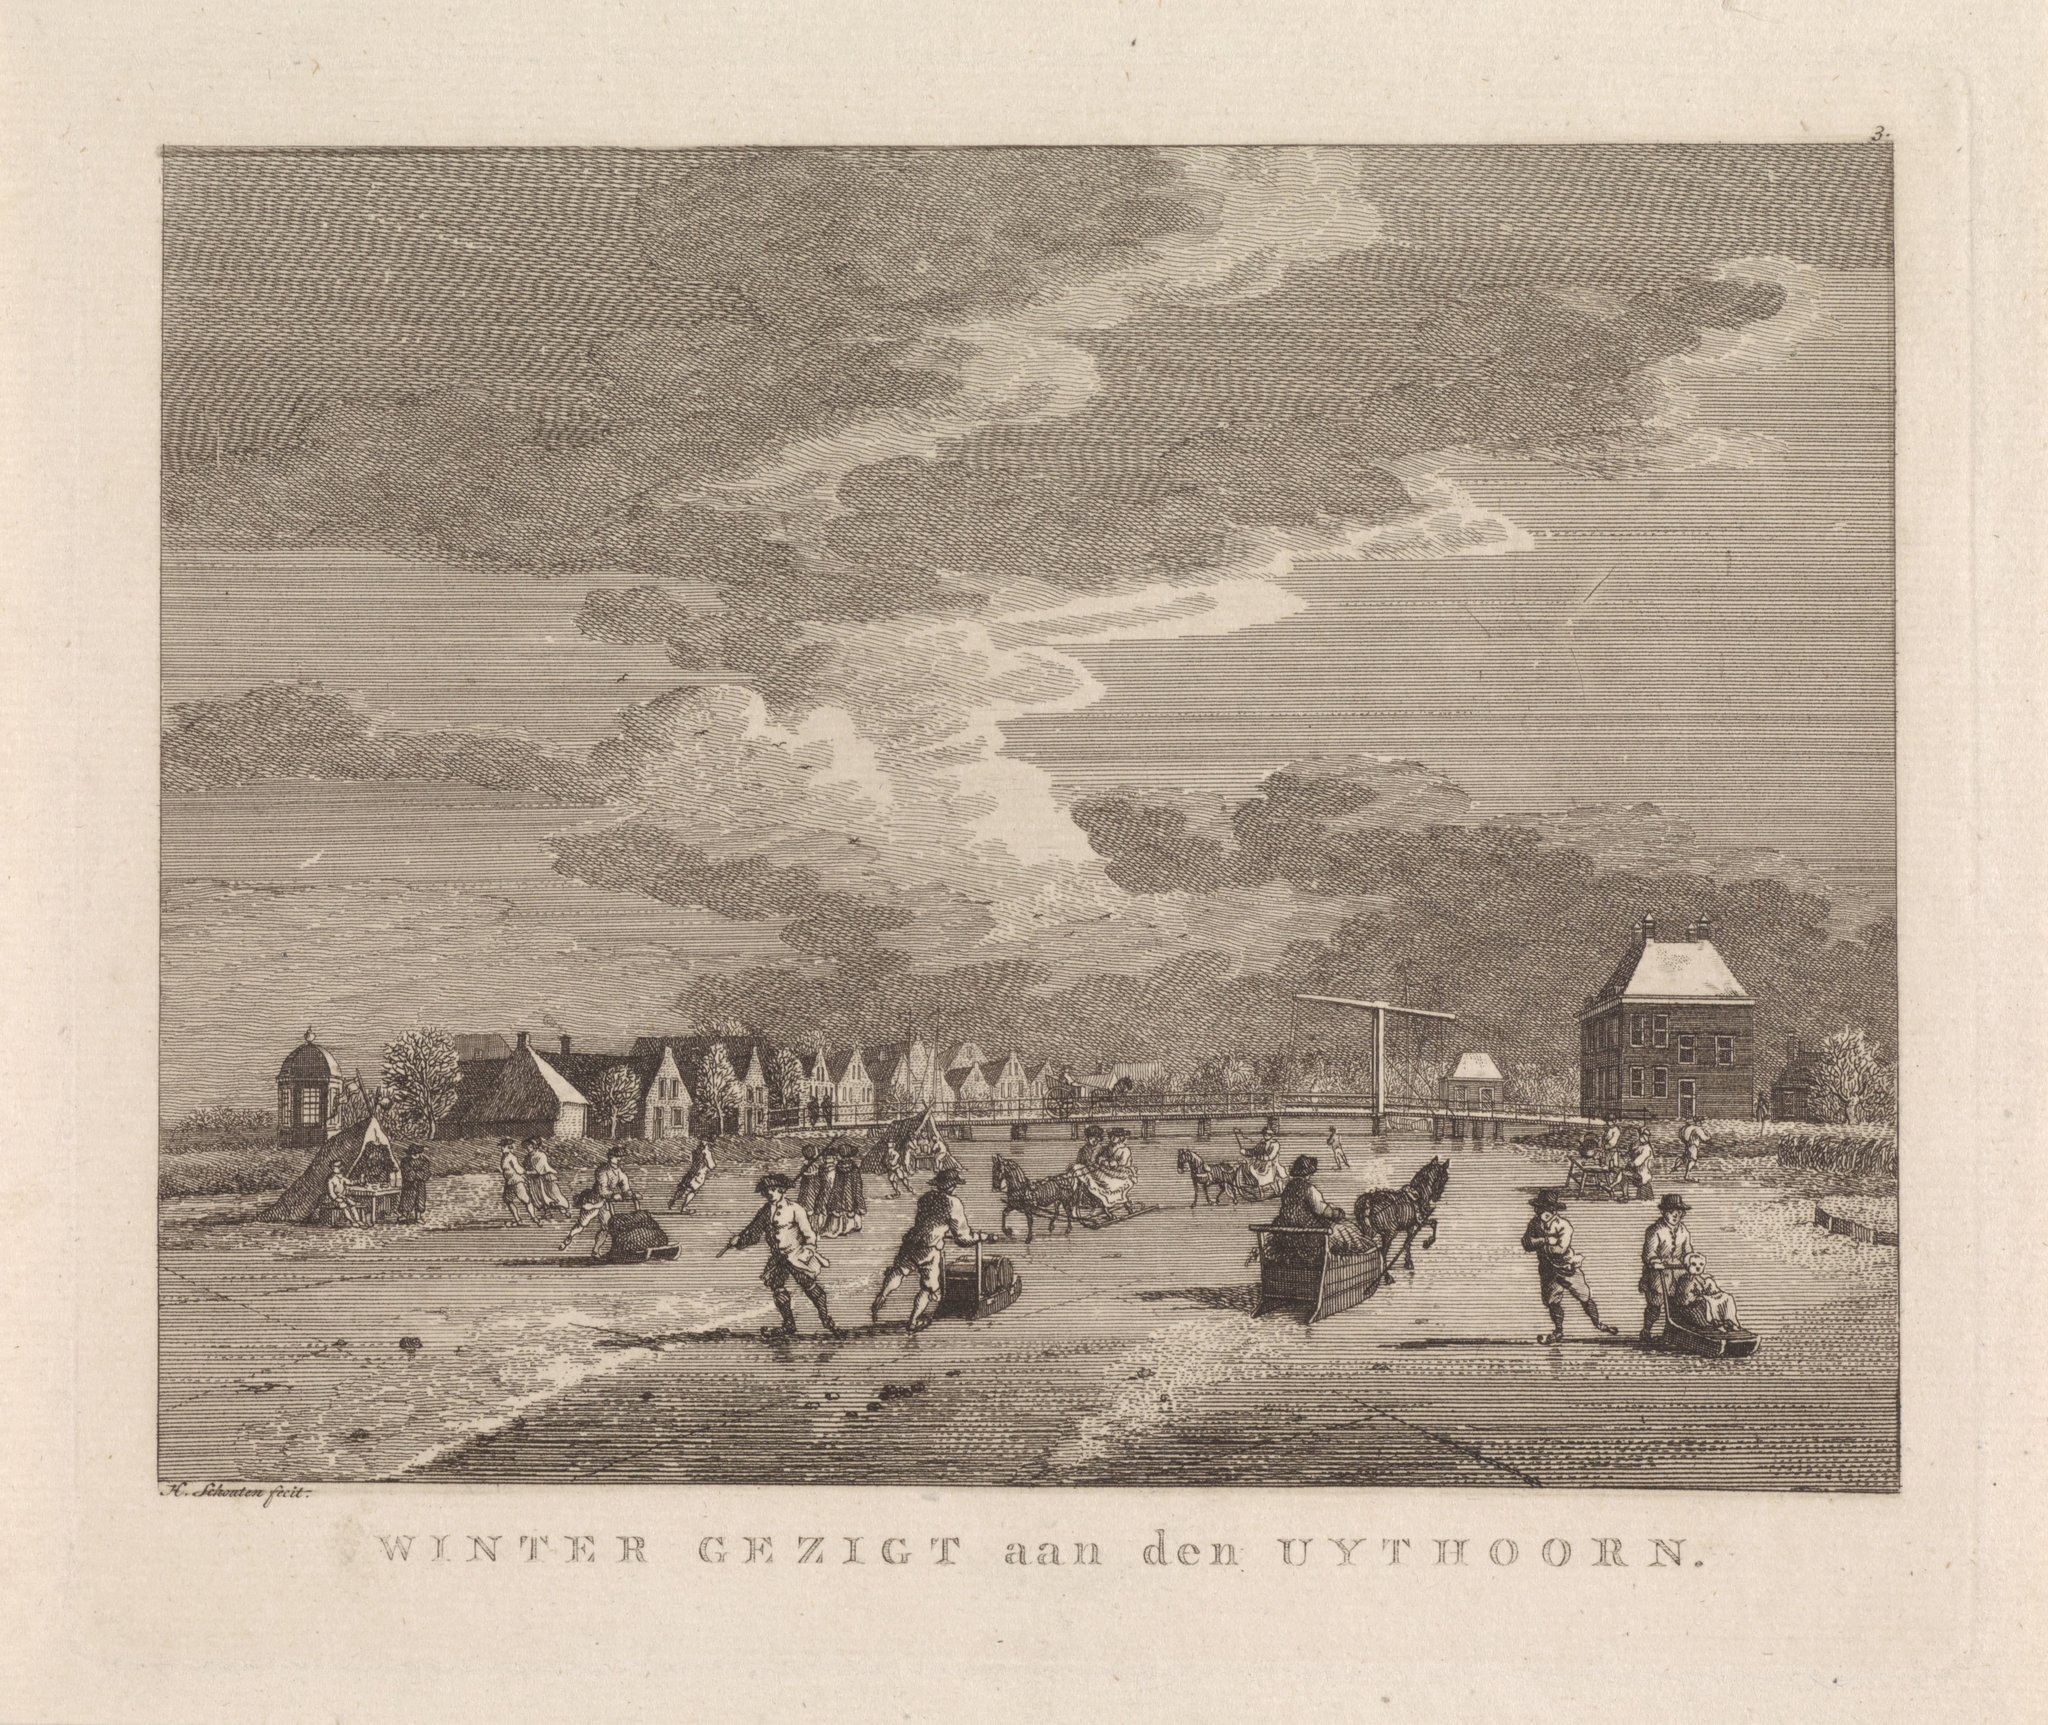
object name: print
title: Winter gezigt aan den Uythoorn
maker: hermanus petrus schouten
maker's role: draughtsman, painter, print maker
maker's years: 1747-1822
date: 1762-1822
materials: paper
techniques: etching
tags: horse-sleigh, stall, booth (~ market), winter ~ human activities (the four seasons of the year), sleigh, sledge (non-sport), skates (winter sports)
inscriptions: collector's mark: Lugt 2228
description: Op een dichtgevroren vaart wordt geschaatst, sleetjes worden voortgeduwd en er rijden arrensleeën. Aan weerszijden een koek en zopiekraam. Op de achtergrond zicht op Uithoorn. Rechtsboven genummerd "3".